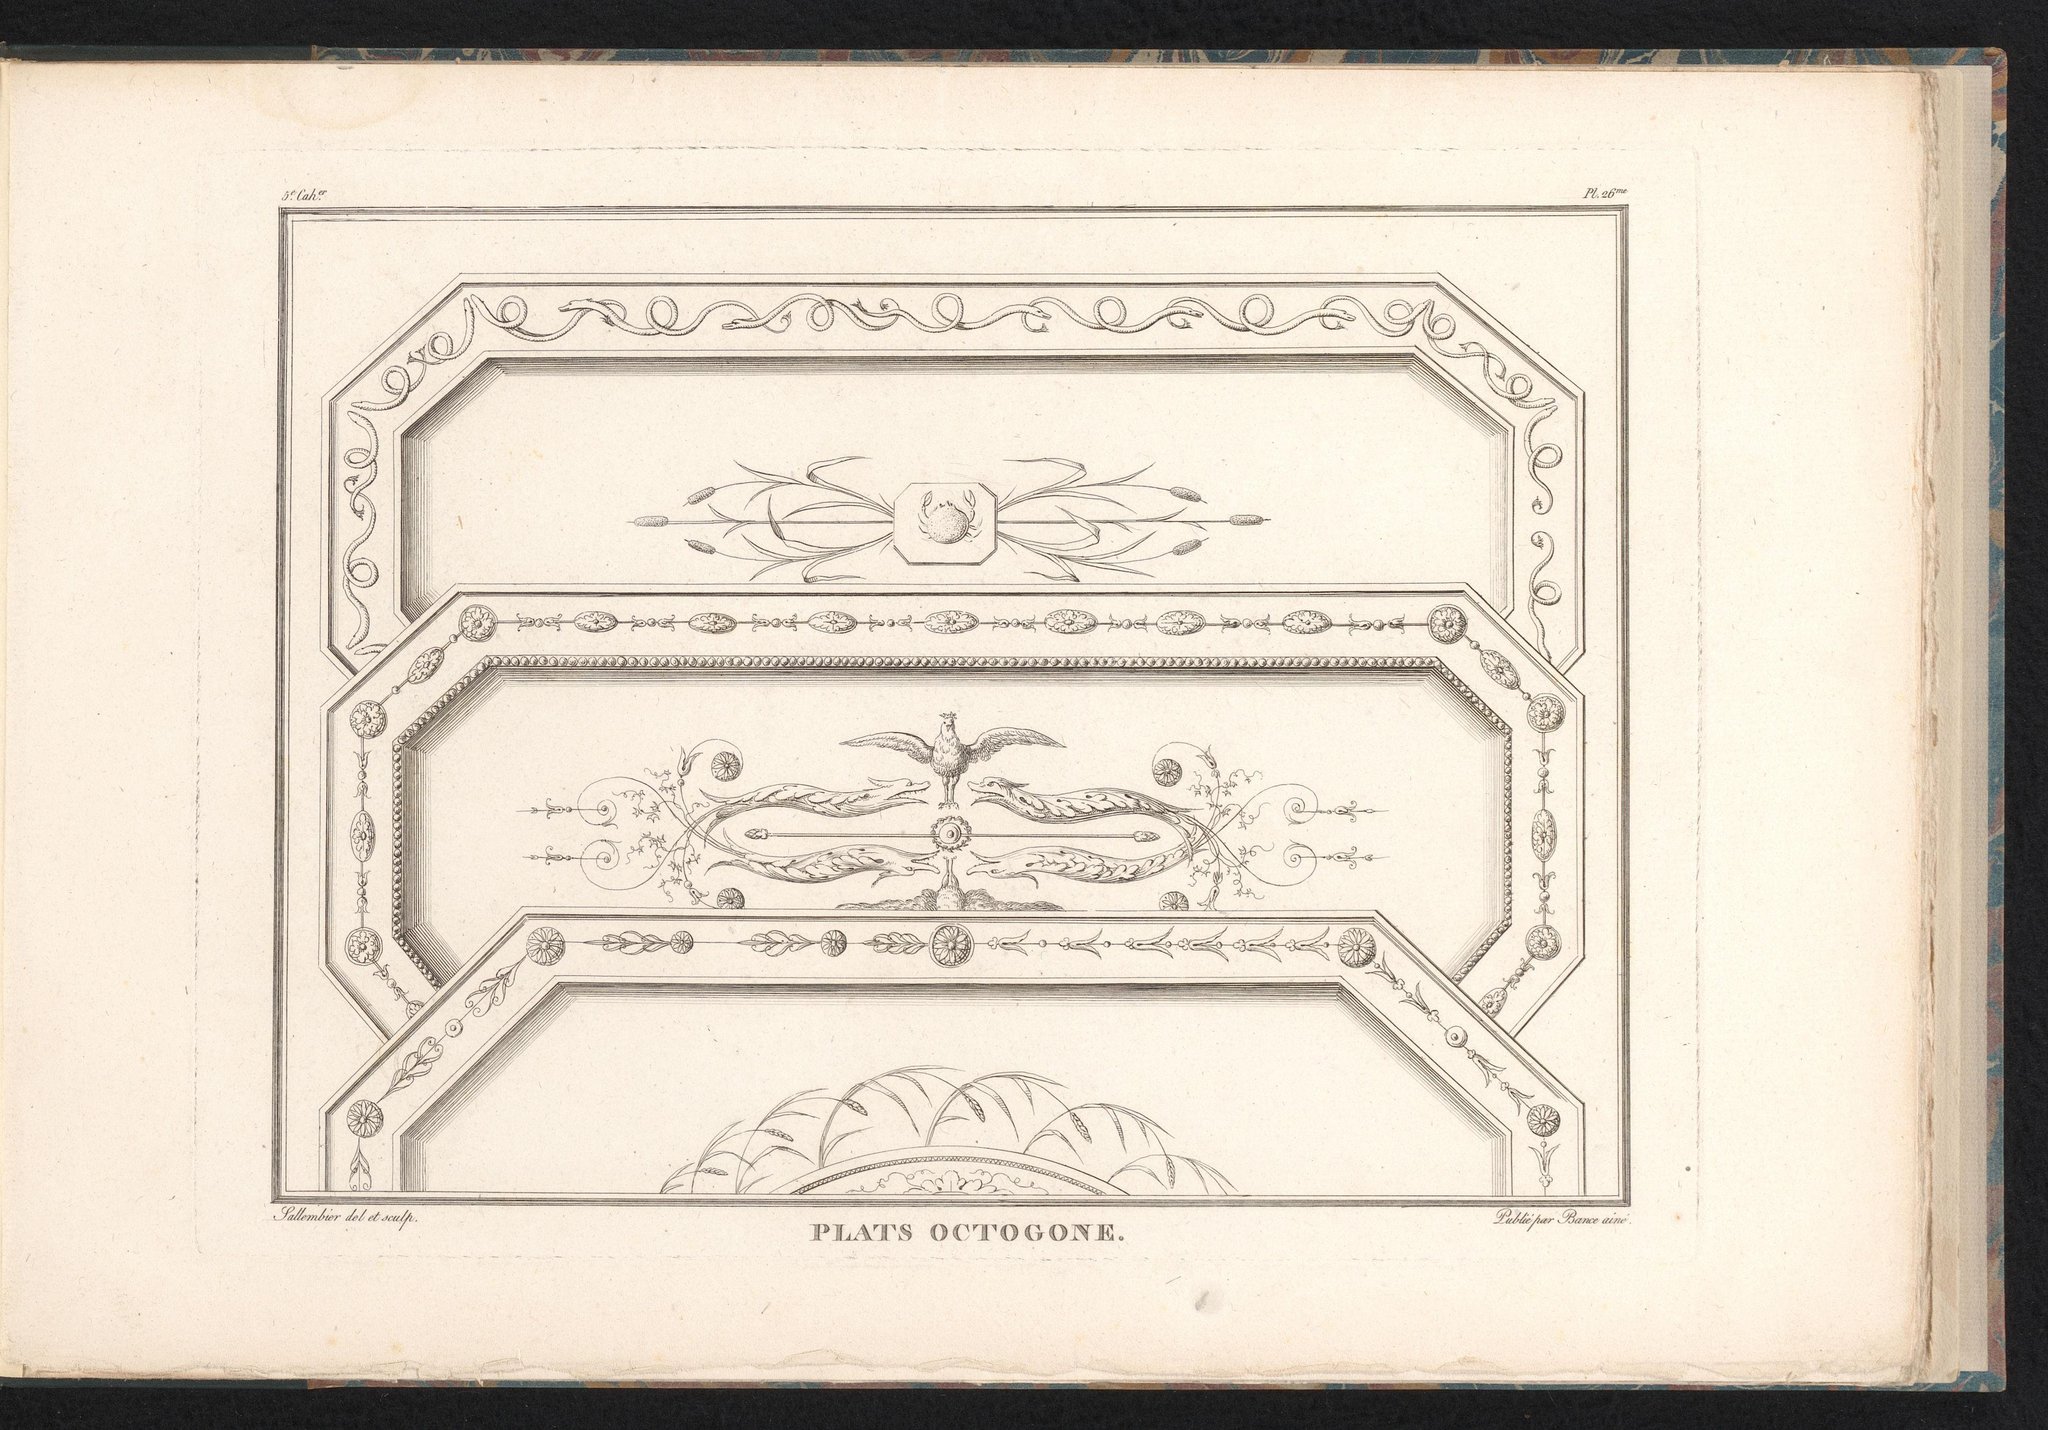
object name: ornament print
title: Achthoekige schalen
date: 1805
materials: paper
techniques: etching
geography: paris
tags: dish, plate, saucer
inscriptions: number: ‘5.e Cah.er’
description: Ontwerpen voor drie platte achthoekige schalen of borden. Prent maakt deel uit van een album.